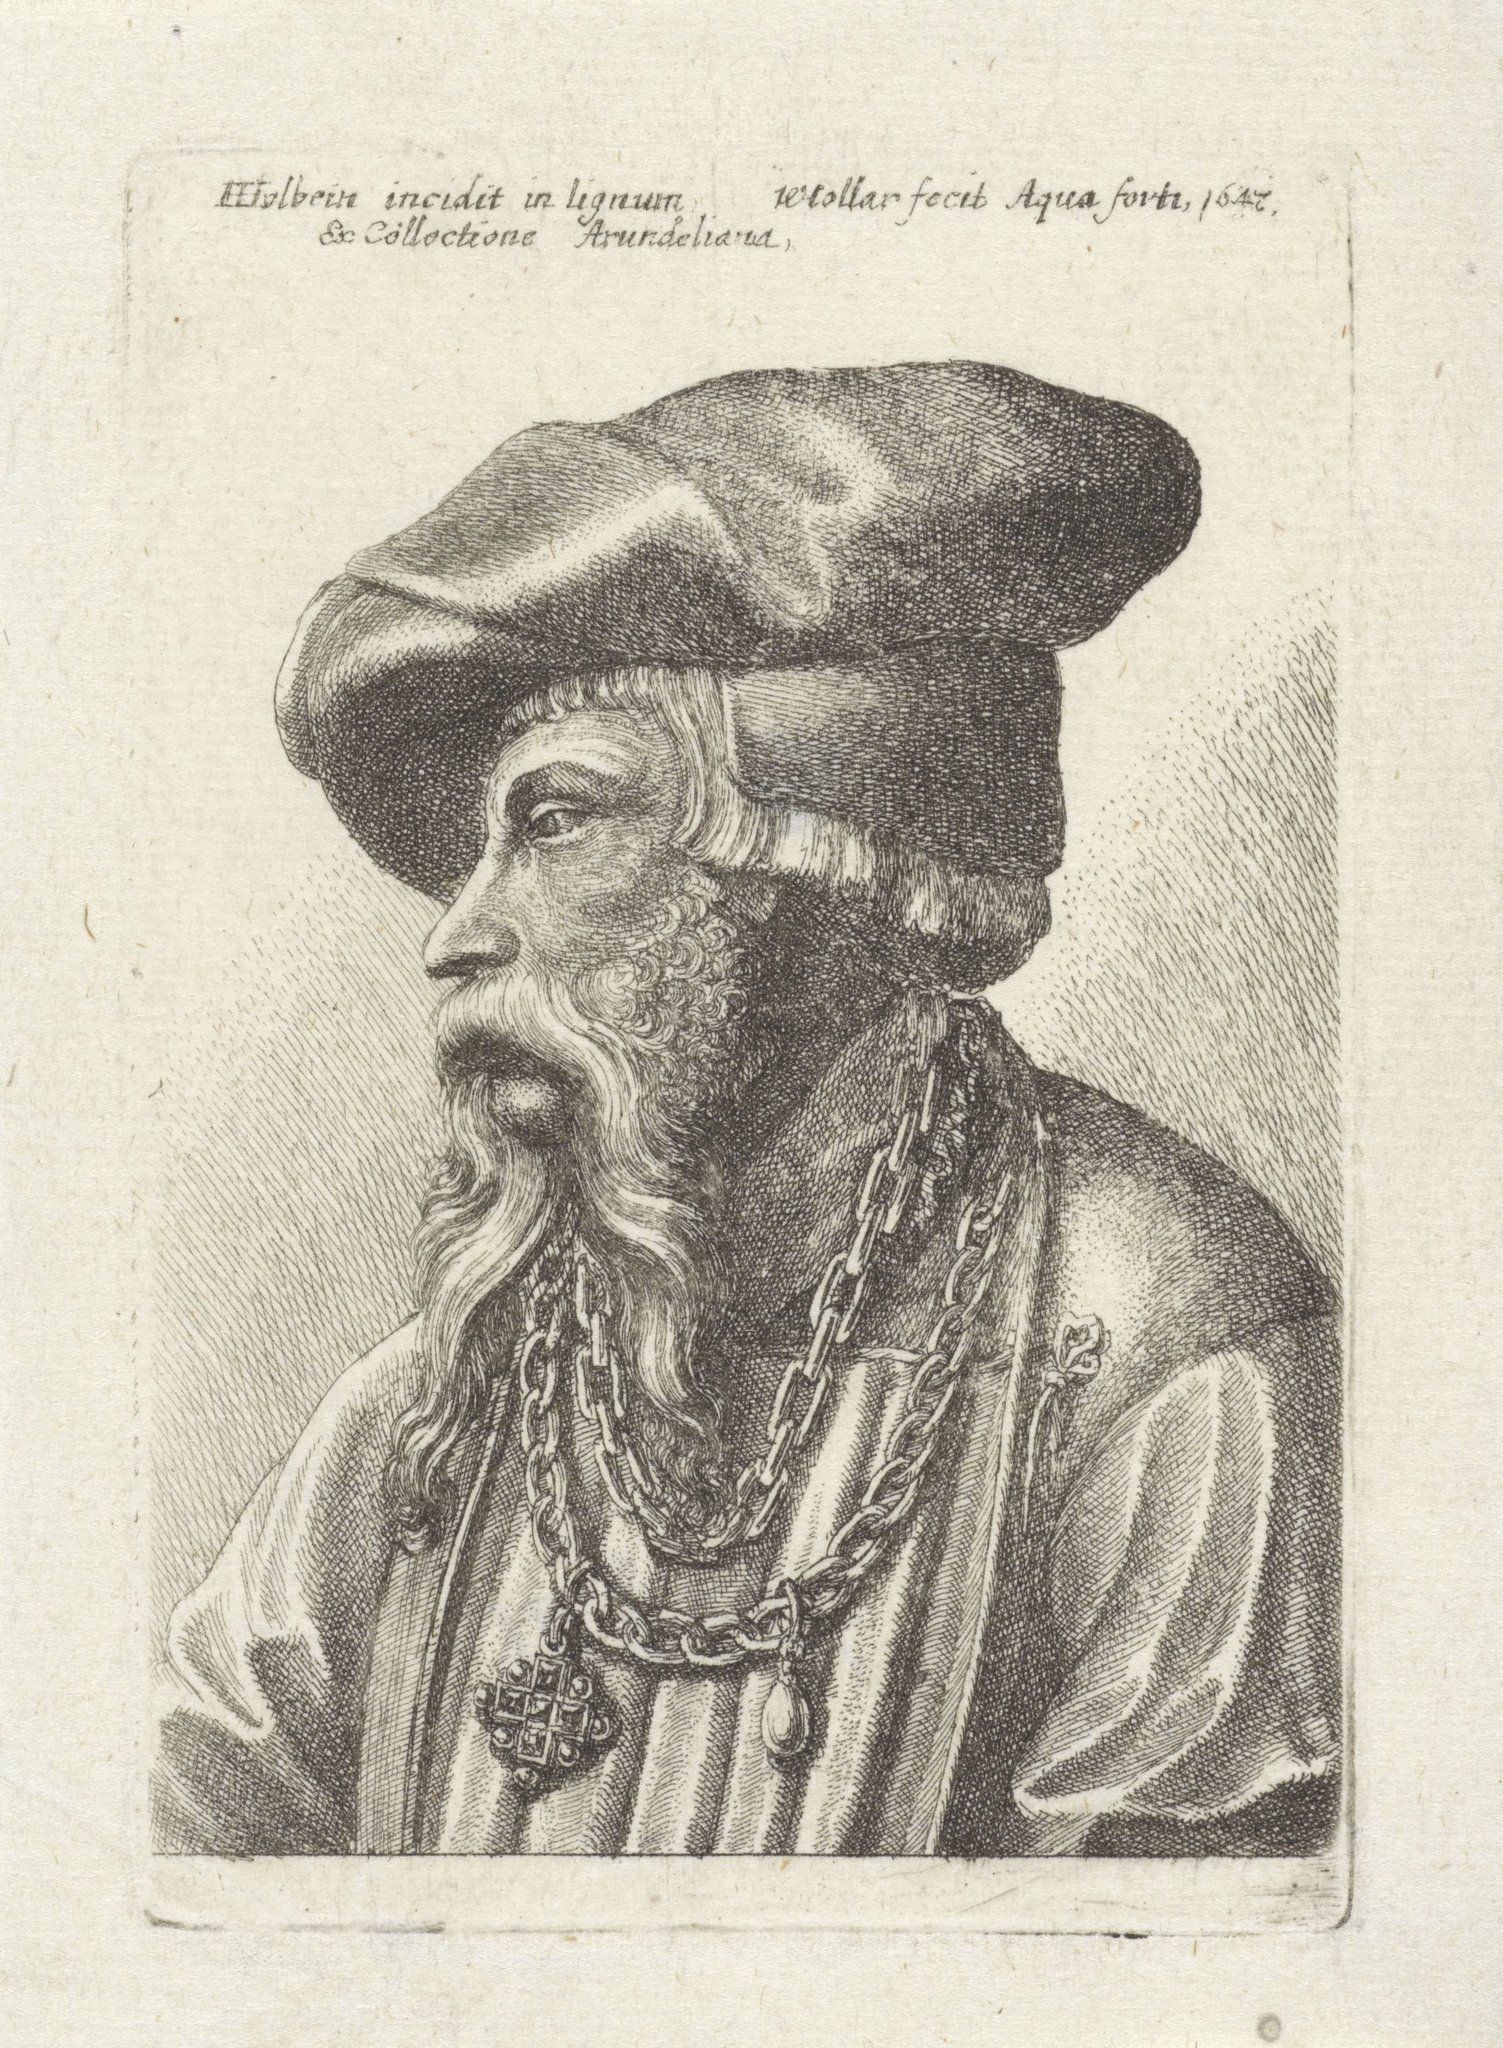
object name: print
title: Portret van een man met baard, baret en halsketting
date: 1647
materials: paper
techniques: etching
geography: antwerp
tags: anonymous historical person portrayed alone, head-gear: cap (+ men's clothes), beard, necklace (+ men's clothes)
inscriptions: collector's mark: Lugt 2228, collector's mark: Lugt 2760